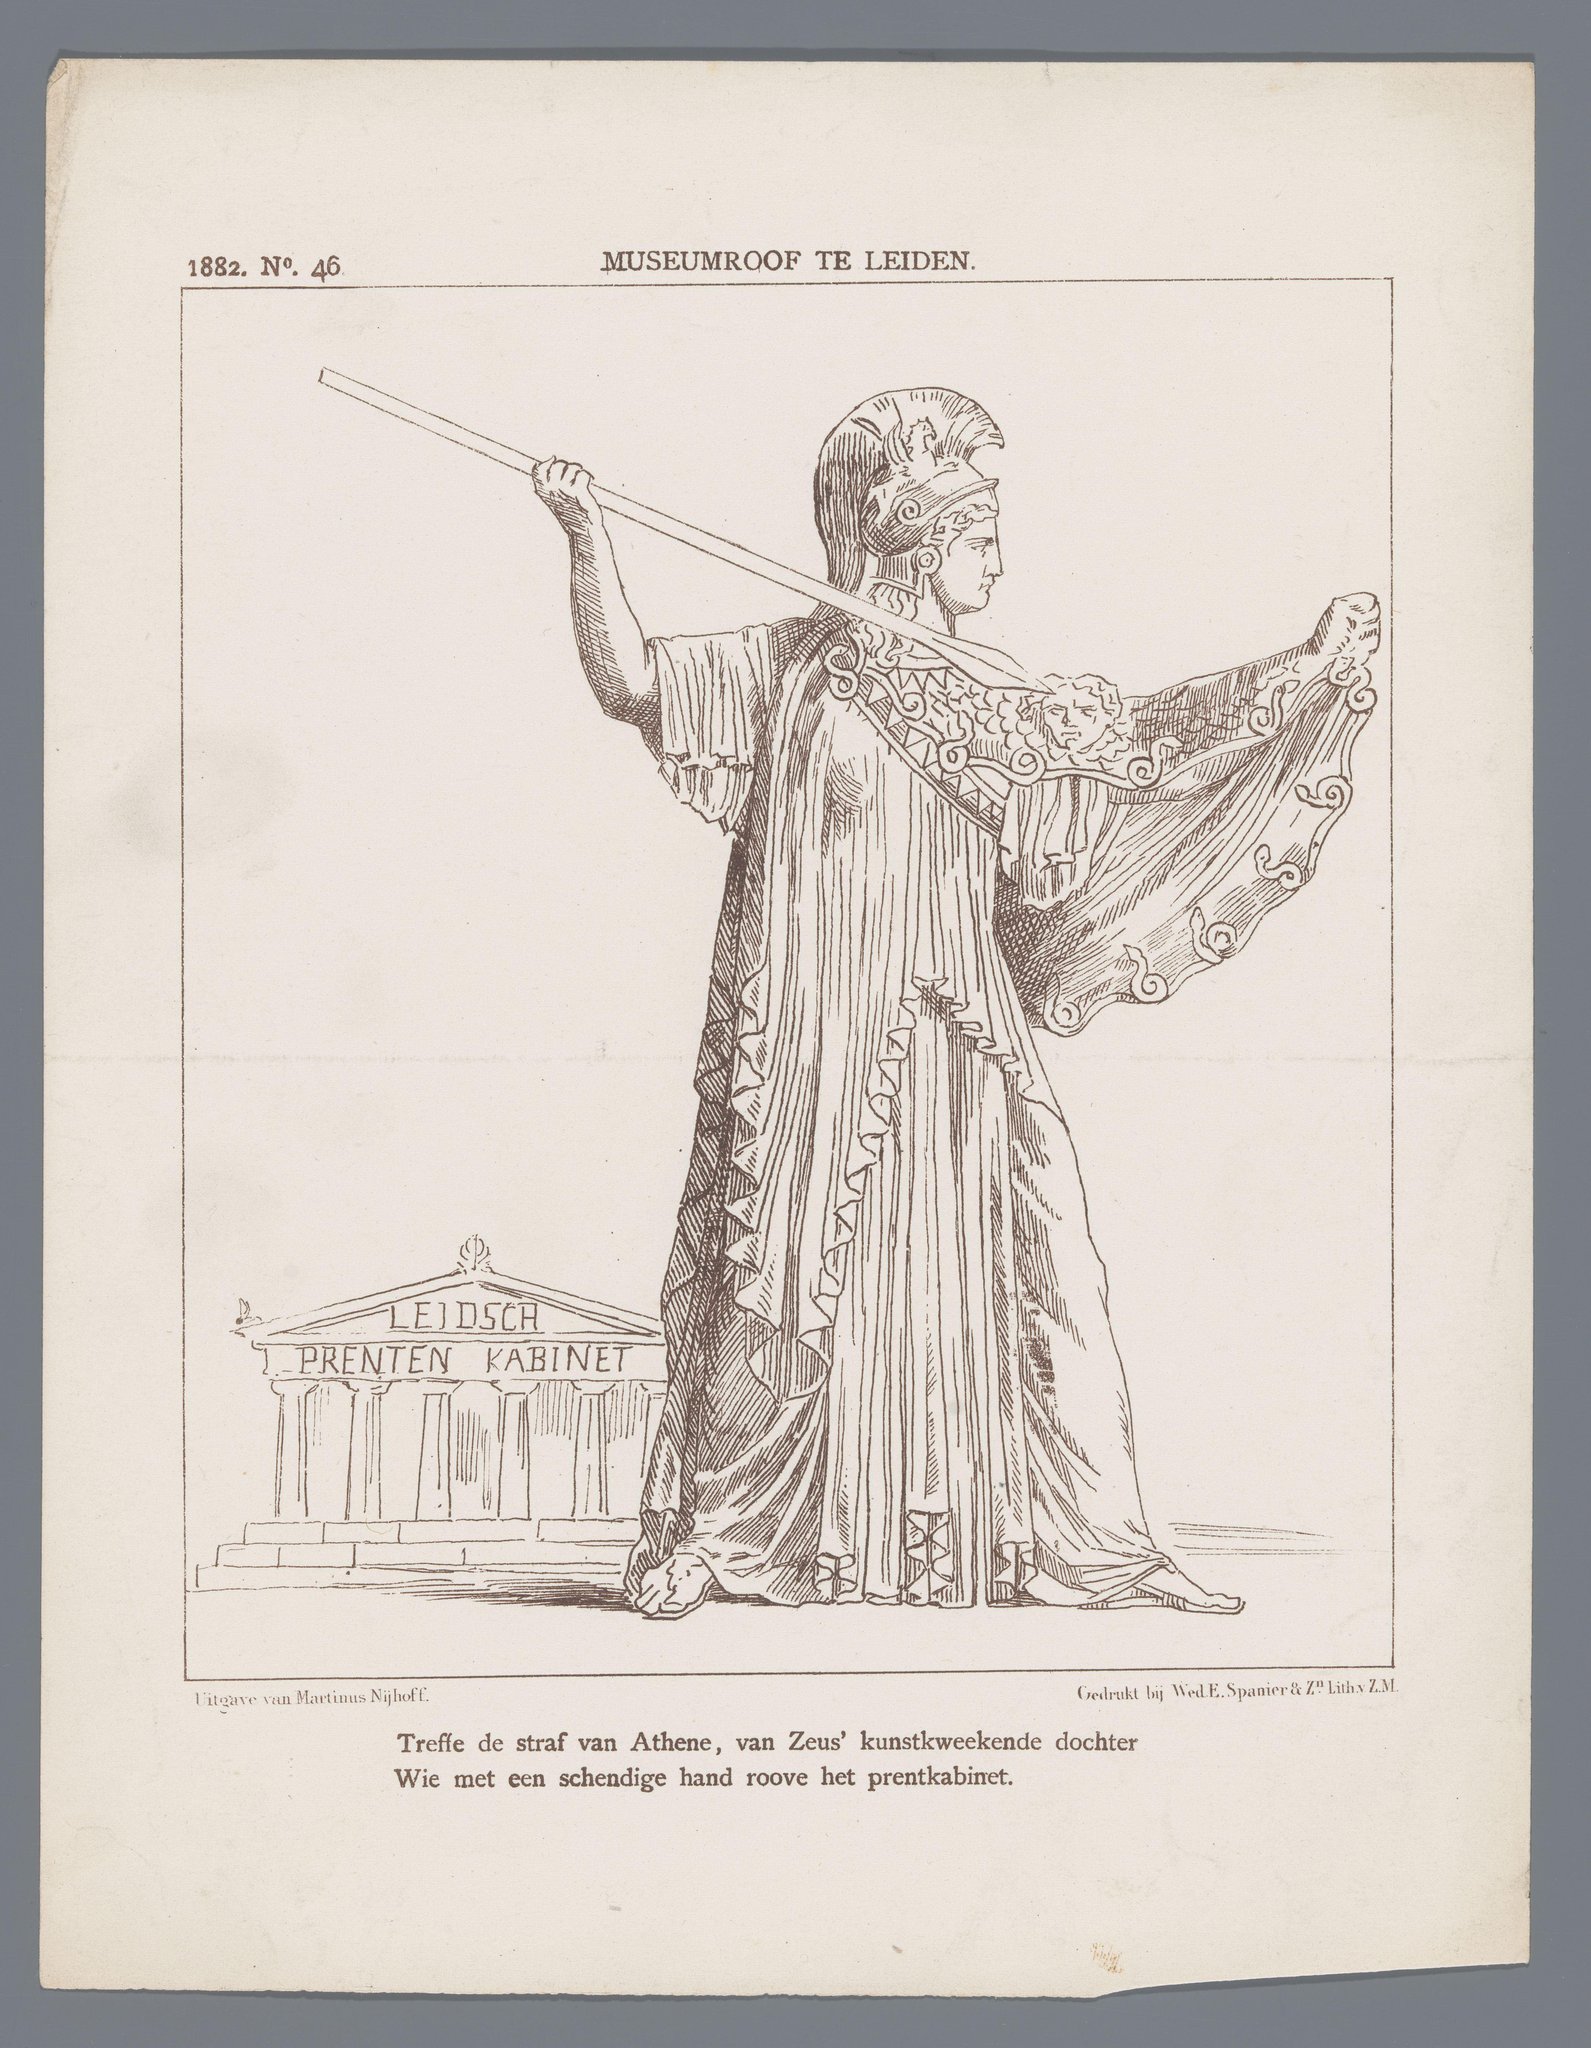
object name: cartoon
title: Museumroof te Leiden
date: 1882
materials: paper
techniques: lithograph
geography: netherlands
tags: leiden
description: Spotprent over de diefstal uit het Leidse prentenkabinet, 1882. Minerva trekt ten strijde. Plaat verschenen bij het weekblad De Nederlandsche Spectator, nr. 46, 1882.